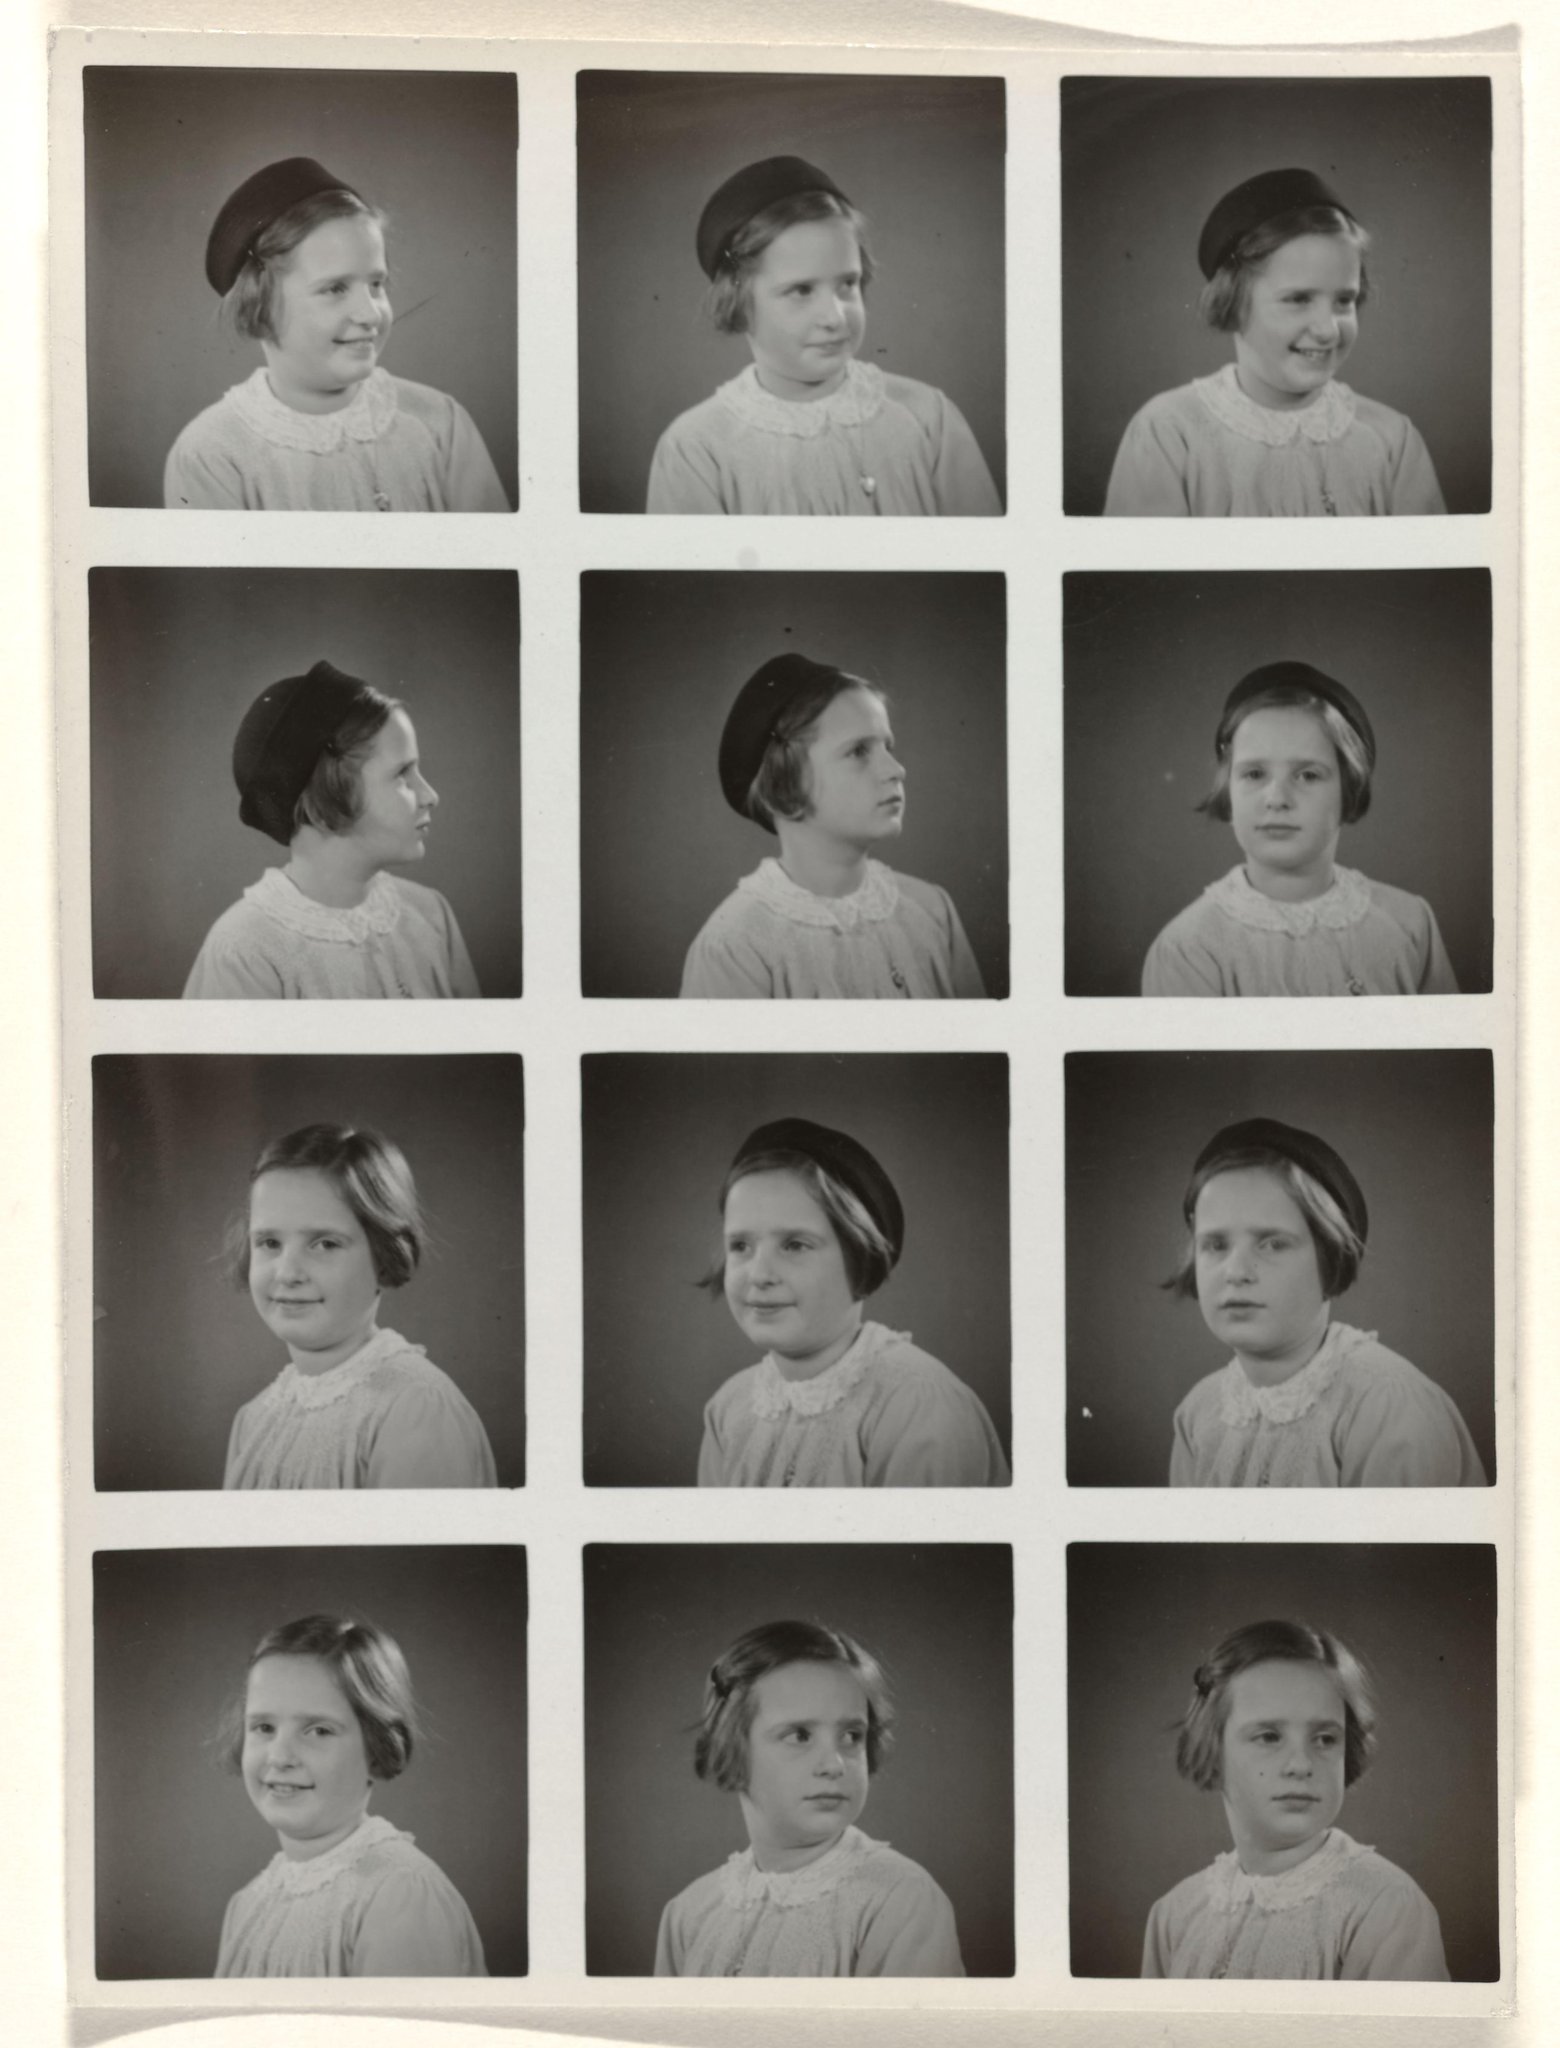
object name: photograph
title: Vel met pasfoto's van Isabel Wachenheimer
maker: Anonymous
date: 1931-1937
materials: photographic support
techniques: gelatin silver print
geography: stuttgart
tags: leiden, isabel wachenheimer-elon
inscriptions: company name: ‘Polyfoto nummer Stuttgart-w. Marienstrasse 2.’